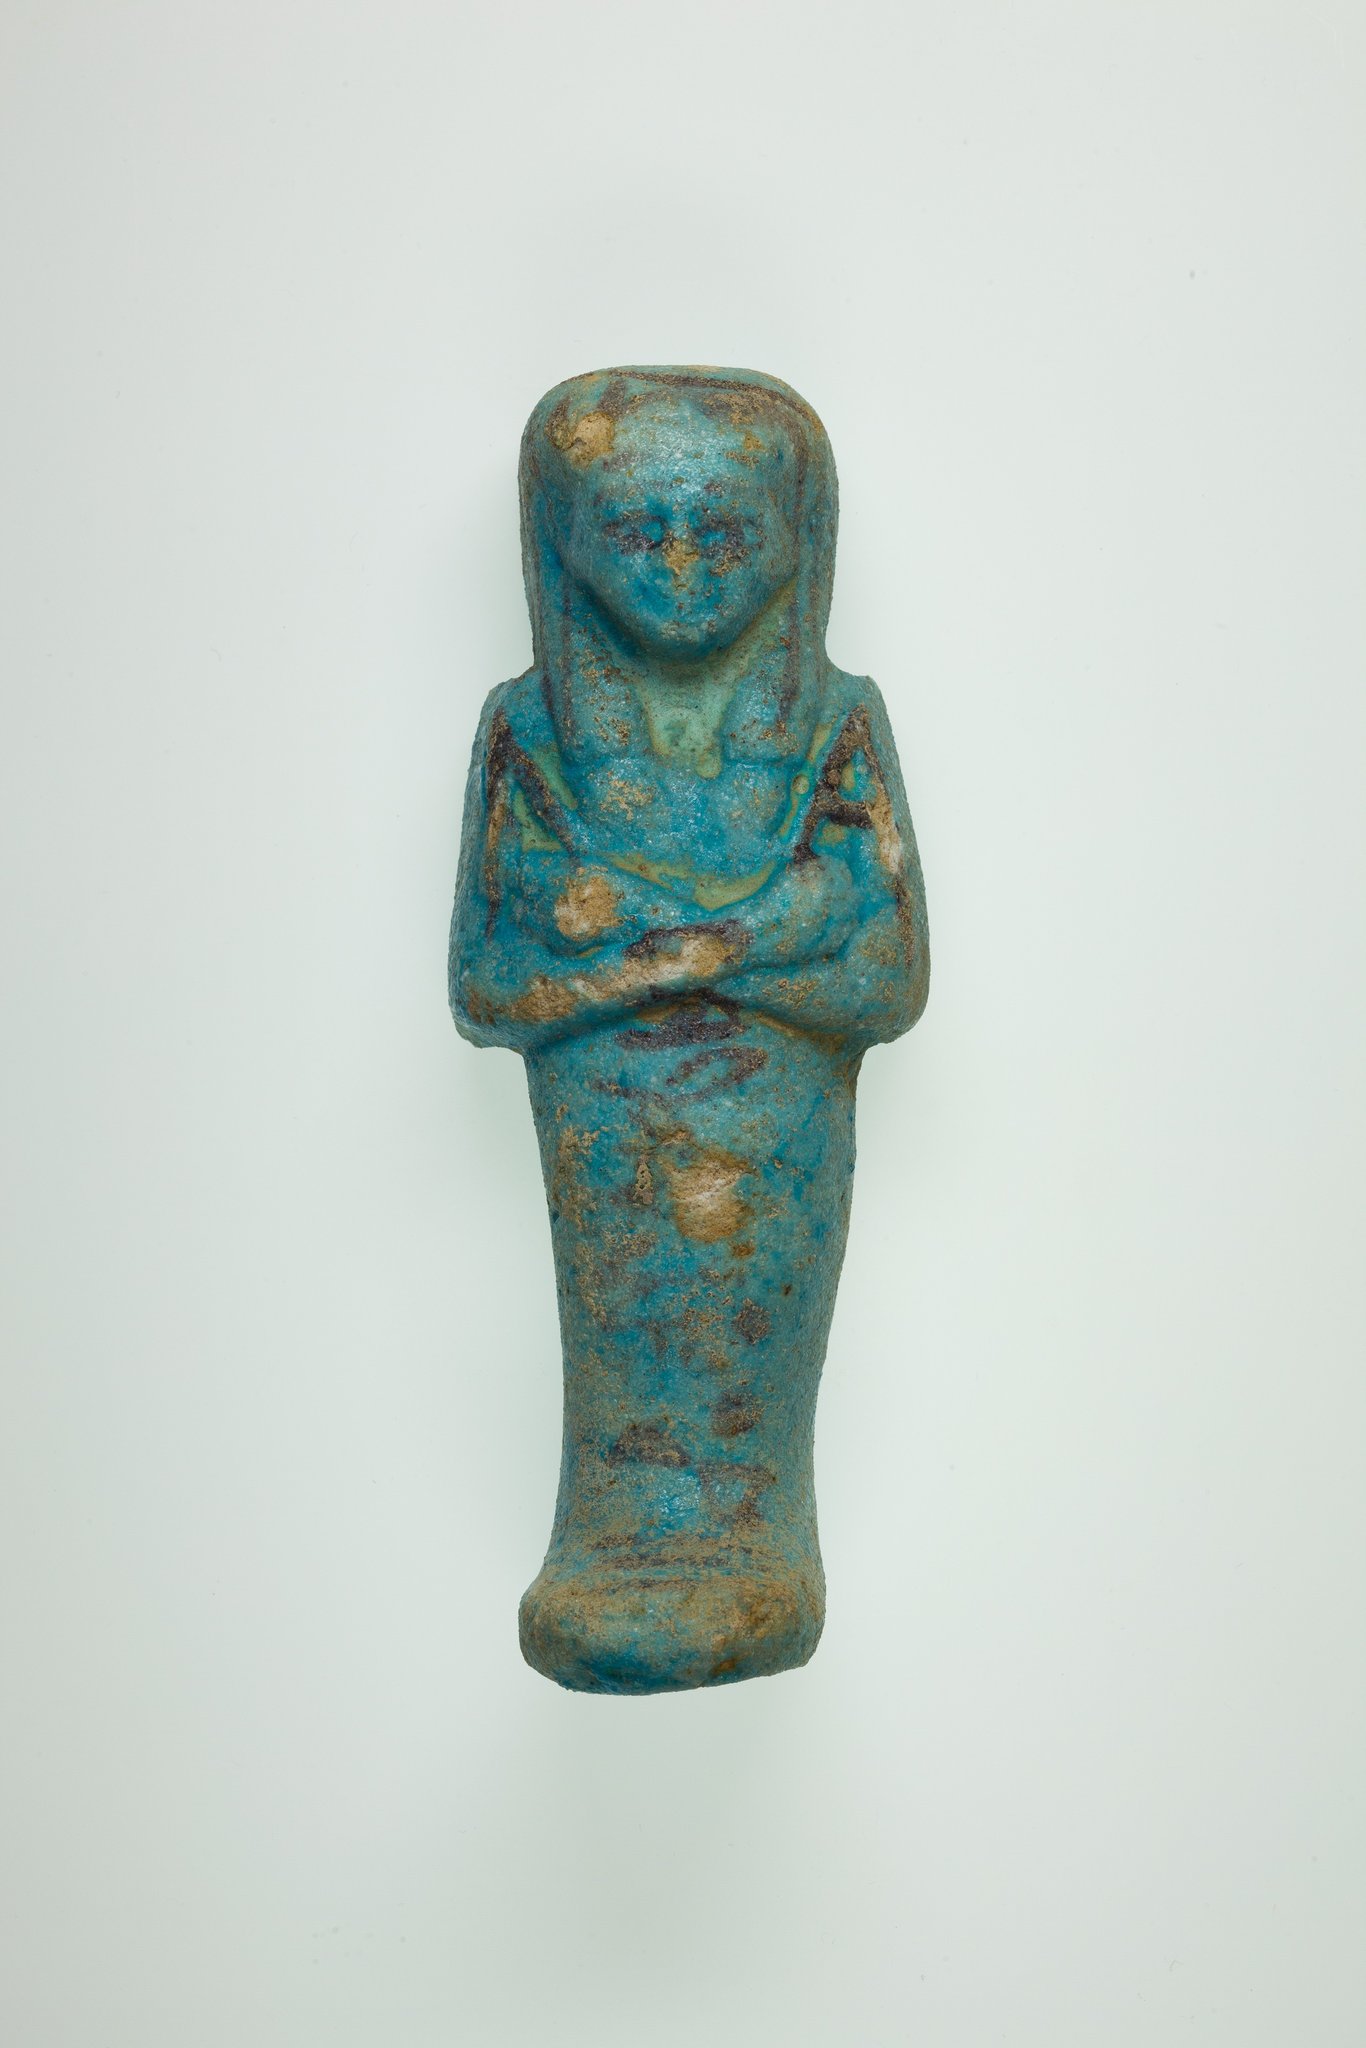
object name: shabti, henettawy c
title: Worker Shabti of Henettawy (C), Daughter of Isetemkheb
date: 990-970 BCE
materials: faience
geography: egypt